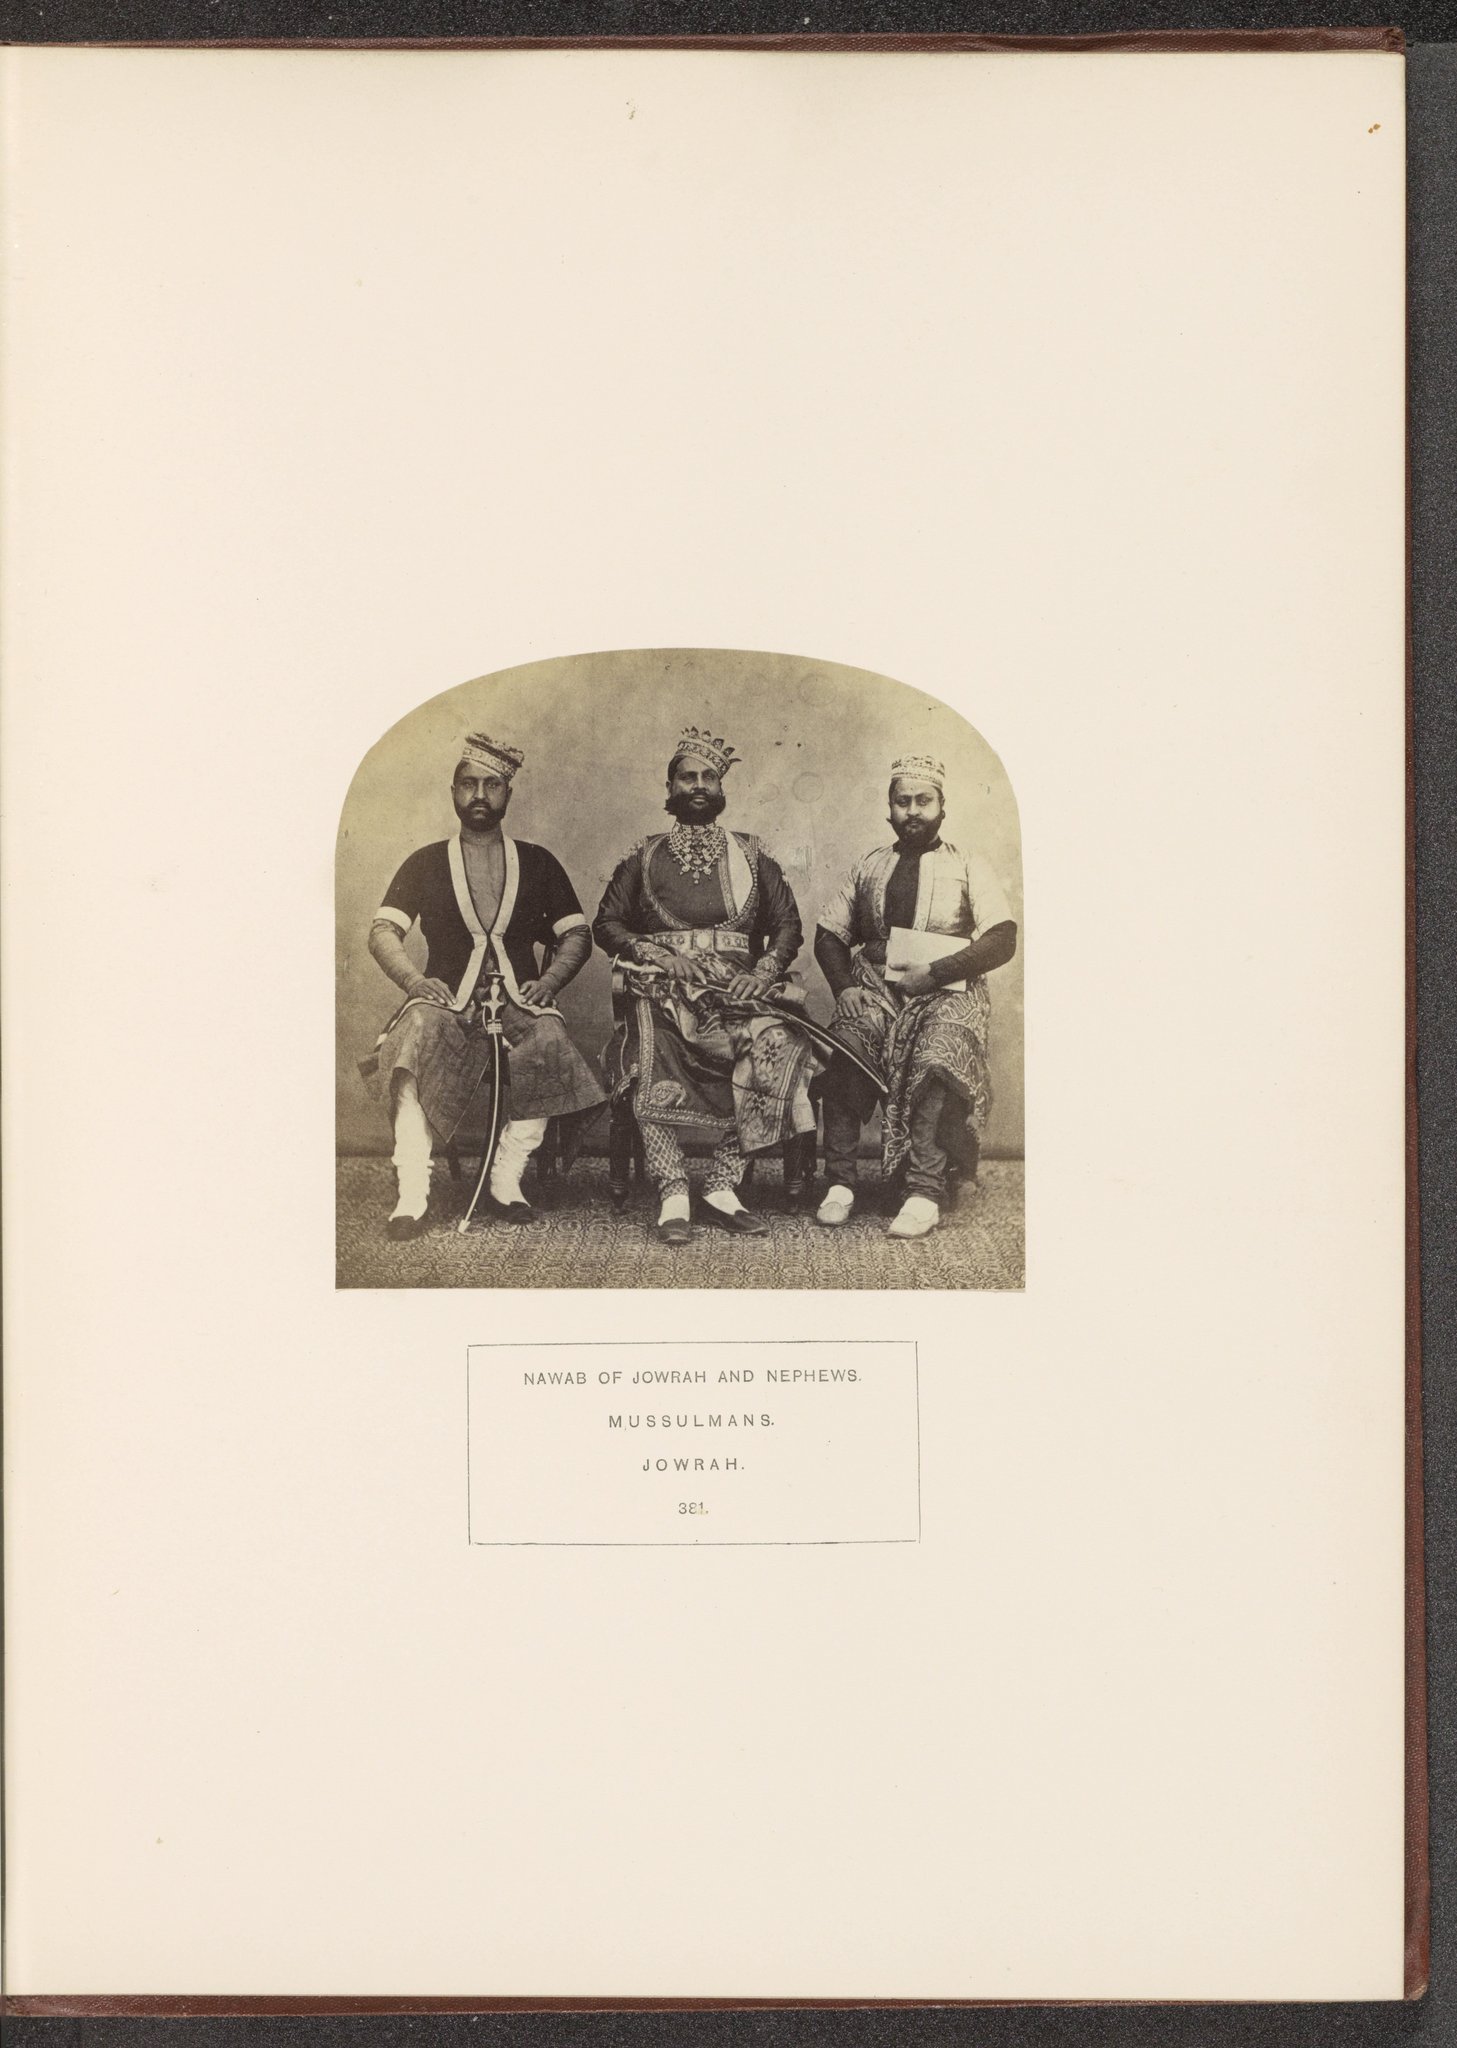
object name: page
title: Portrait of Ghous Mahomed Khan, the Nawab of Jaora, with two nephews, Jaora, Madhya Pradesh, India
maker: james john waterhouse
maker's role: fotograaf, luitenant, officier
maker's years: 1842-1928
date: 1862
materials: photographic support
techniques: albumen print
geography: jaora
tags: hacking and thrusting weapons (with name), ruler, sovereign, human races; peoples; nationalities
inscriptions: number: ‘381.’, inscription: ‘NAWAB OF JOWRAH AND NEPHEWS./ MUSSULMANS./ JOWRAH.’